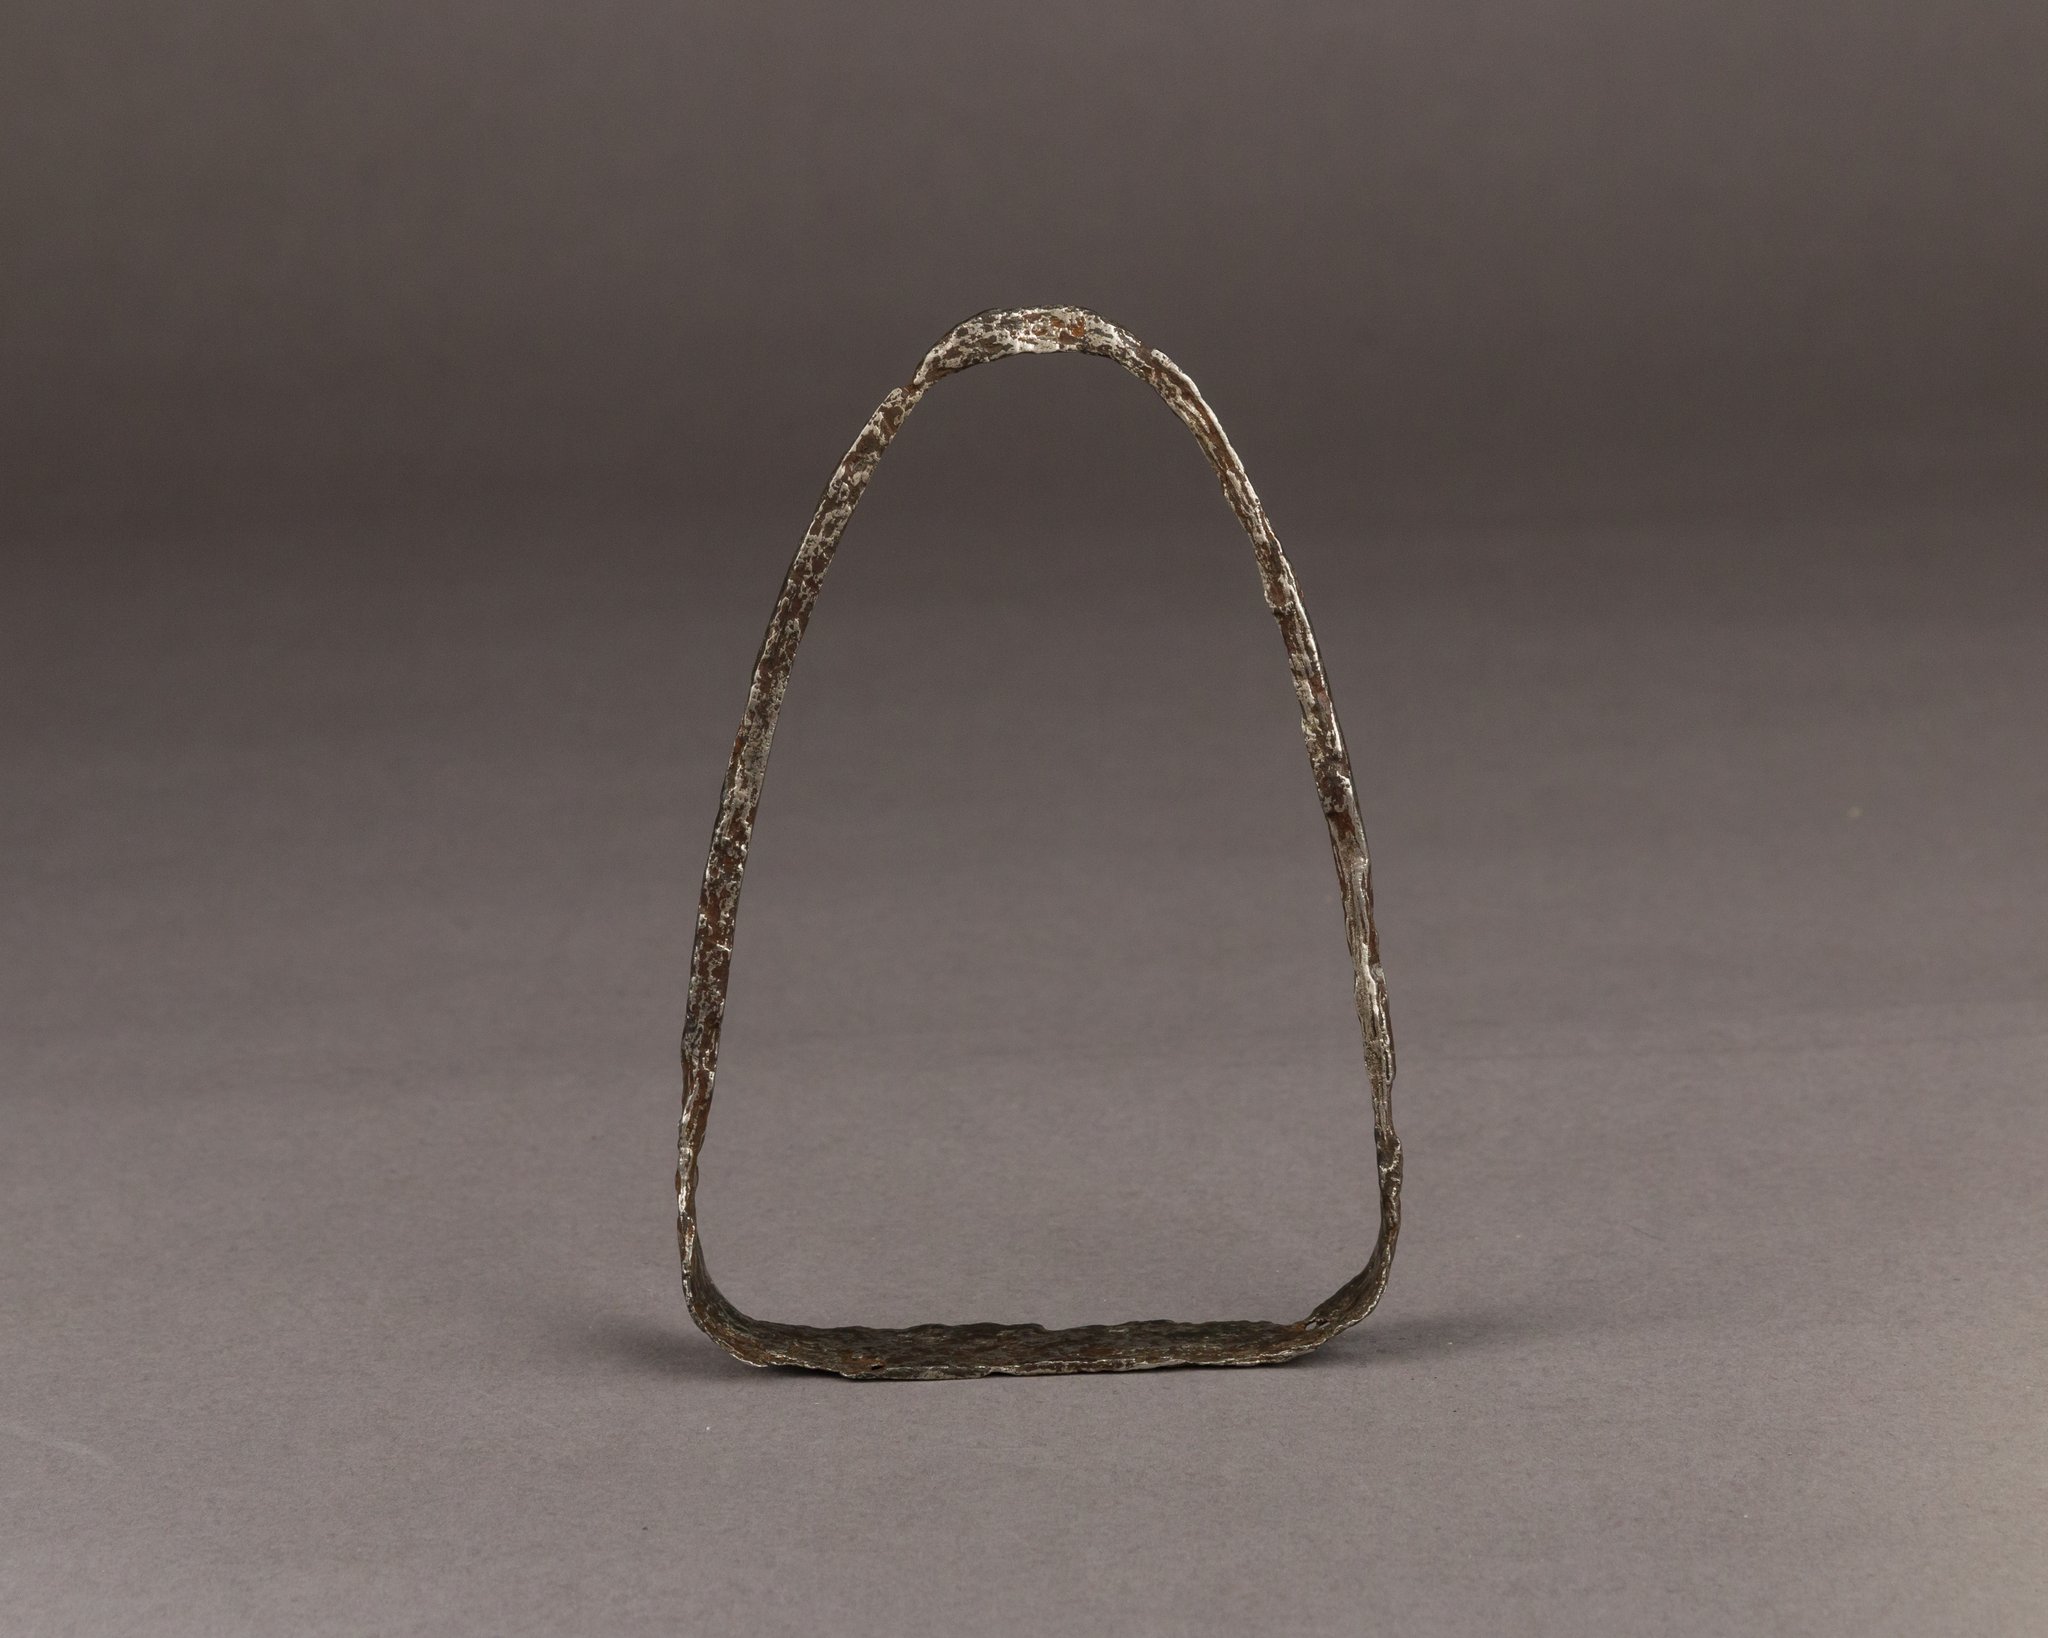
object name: stirrup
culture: west slavic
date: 901-1100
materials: iron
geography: poland